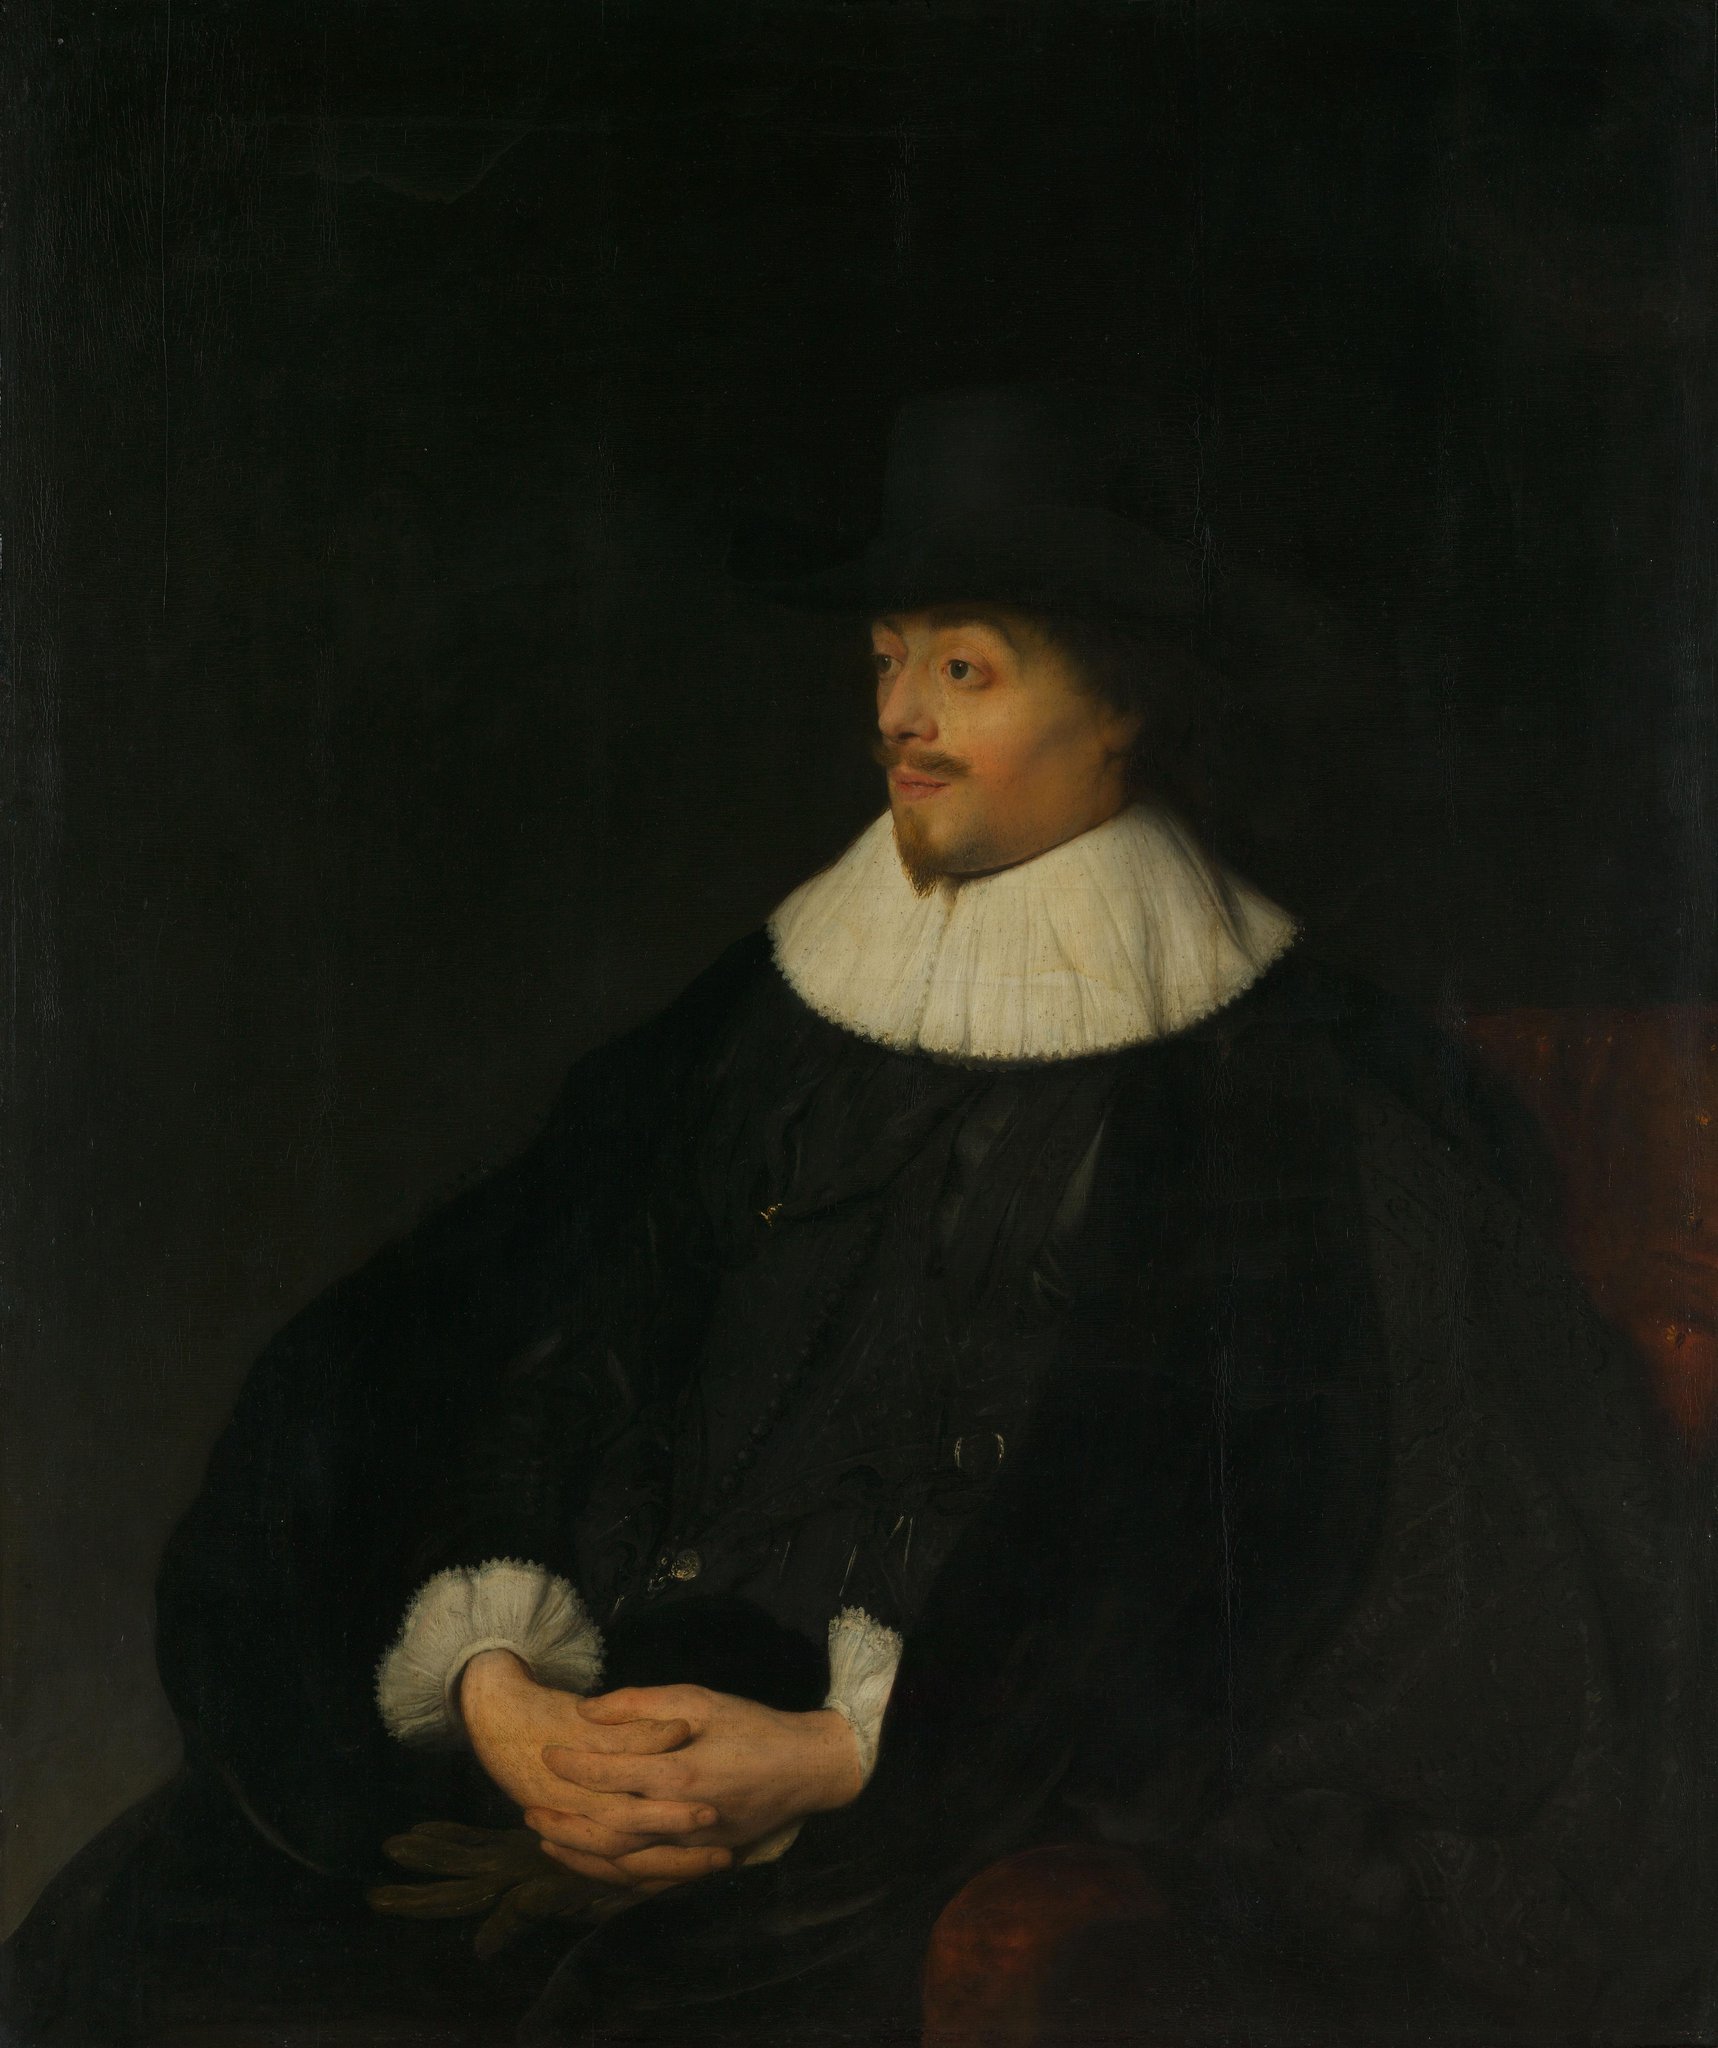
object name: painting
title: Portrait of Constantijn Huygens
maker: jan lievens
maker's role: draughtsman, painter, print maker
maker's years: 1607-1674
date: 1628-1629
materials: oil, panel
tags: the hague, constantijn huygens (i), historical persons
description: Constantijn Huygens was secretary to Stadtholder Frederick Henry and a notable connoisseur. In his autobiography, he described how this painting was executed. Lievens painted the portrait in two stages, first the clothing and the hands, and then the face. This explains why the scale is a bit off: the head is too small in relation to the body.